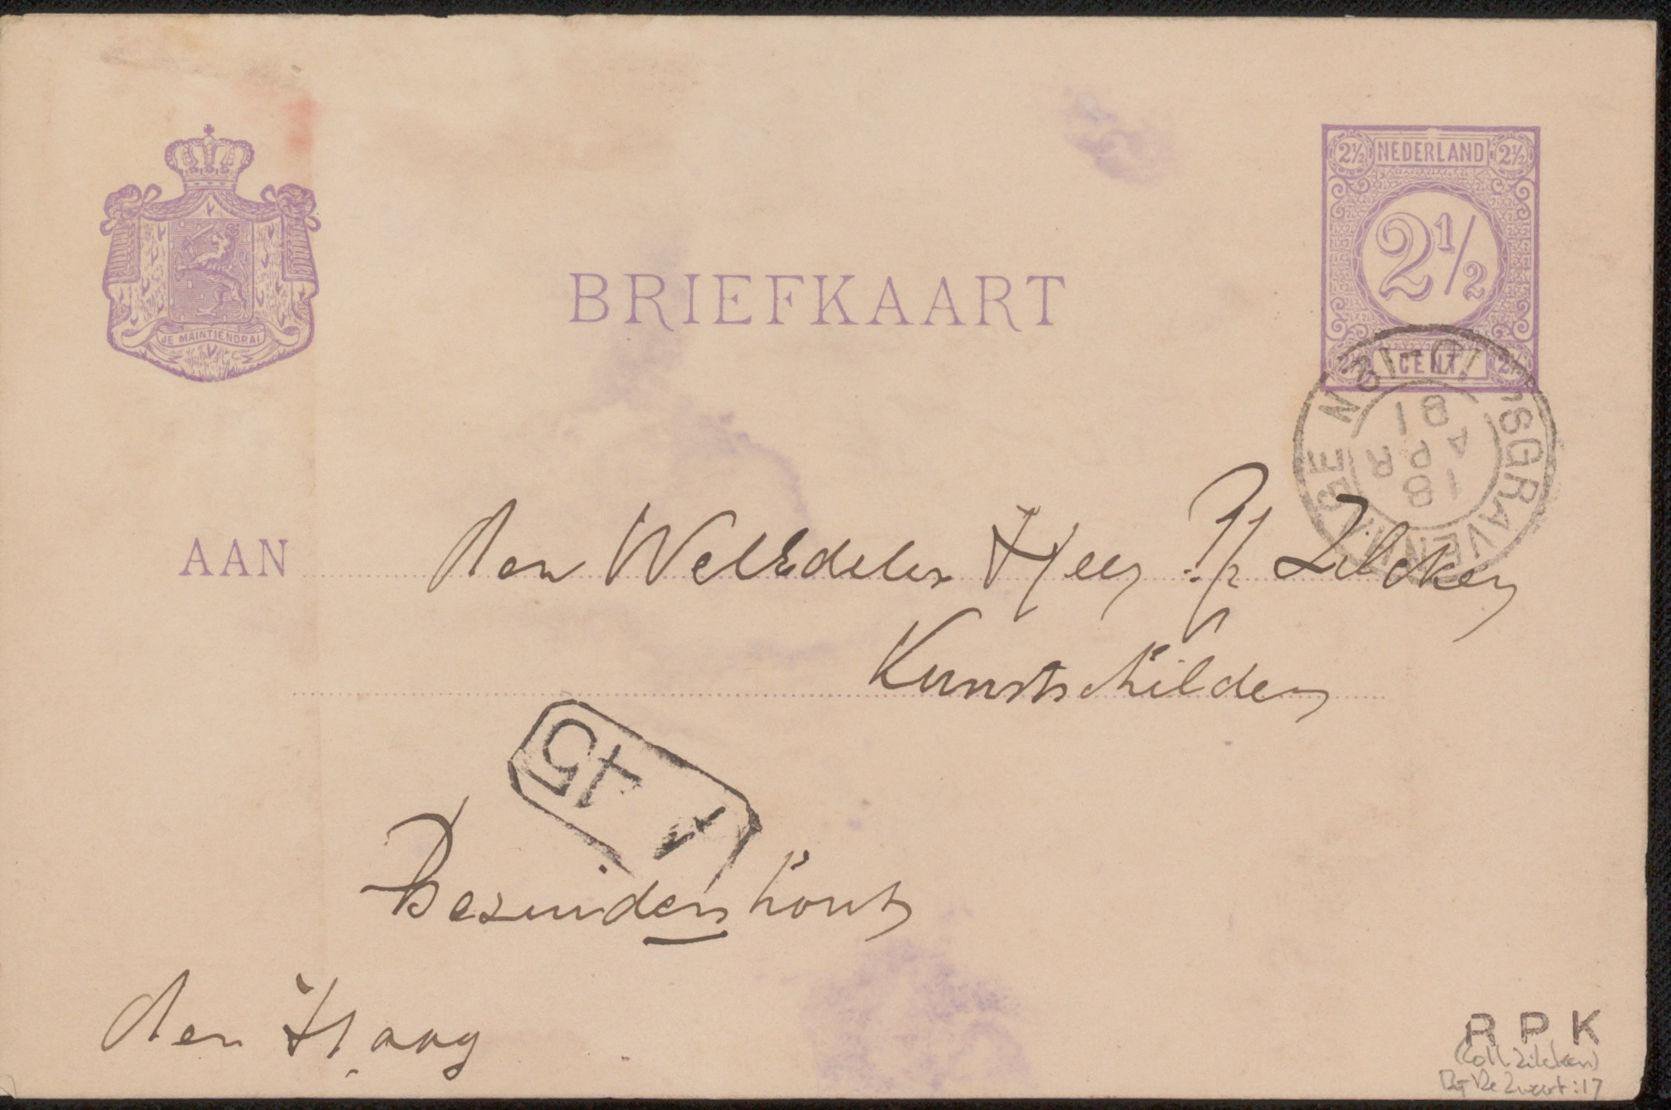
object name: postcard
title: Briefkaart aan Philip Zilcken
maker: willem de zwart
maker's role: draughtsman, painter, print maker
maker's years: 1862-1931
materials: cardboard, ink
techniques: pen, writing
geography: the hague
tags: draughtsman, philip zilcken, diseases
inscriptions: collector's mark: ‘RPK’